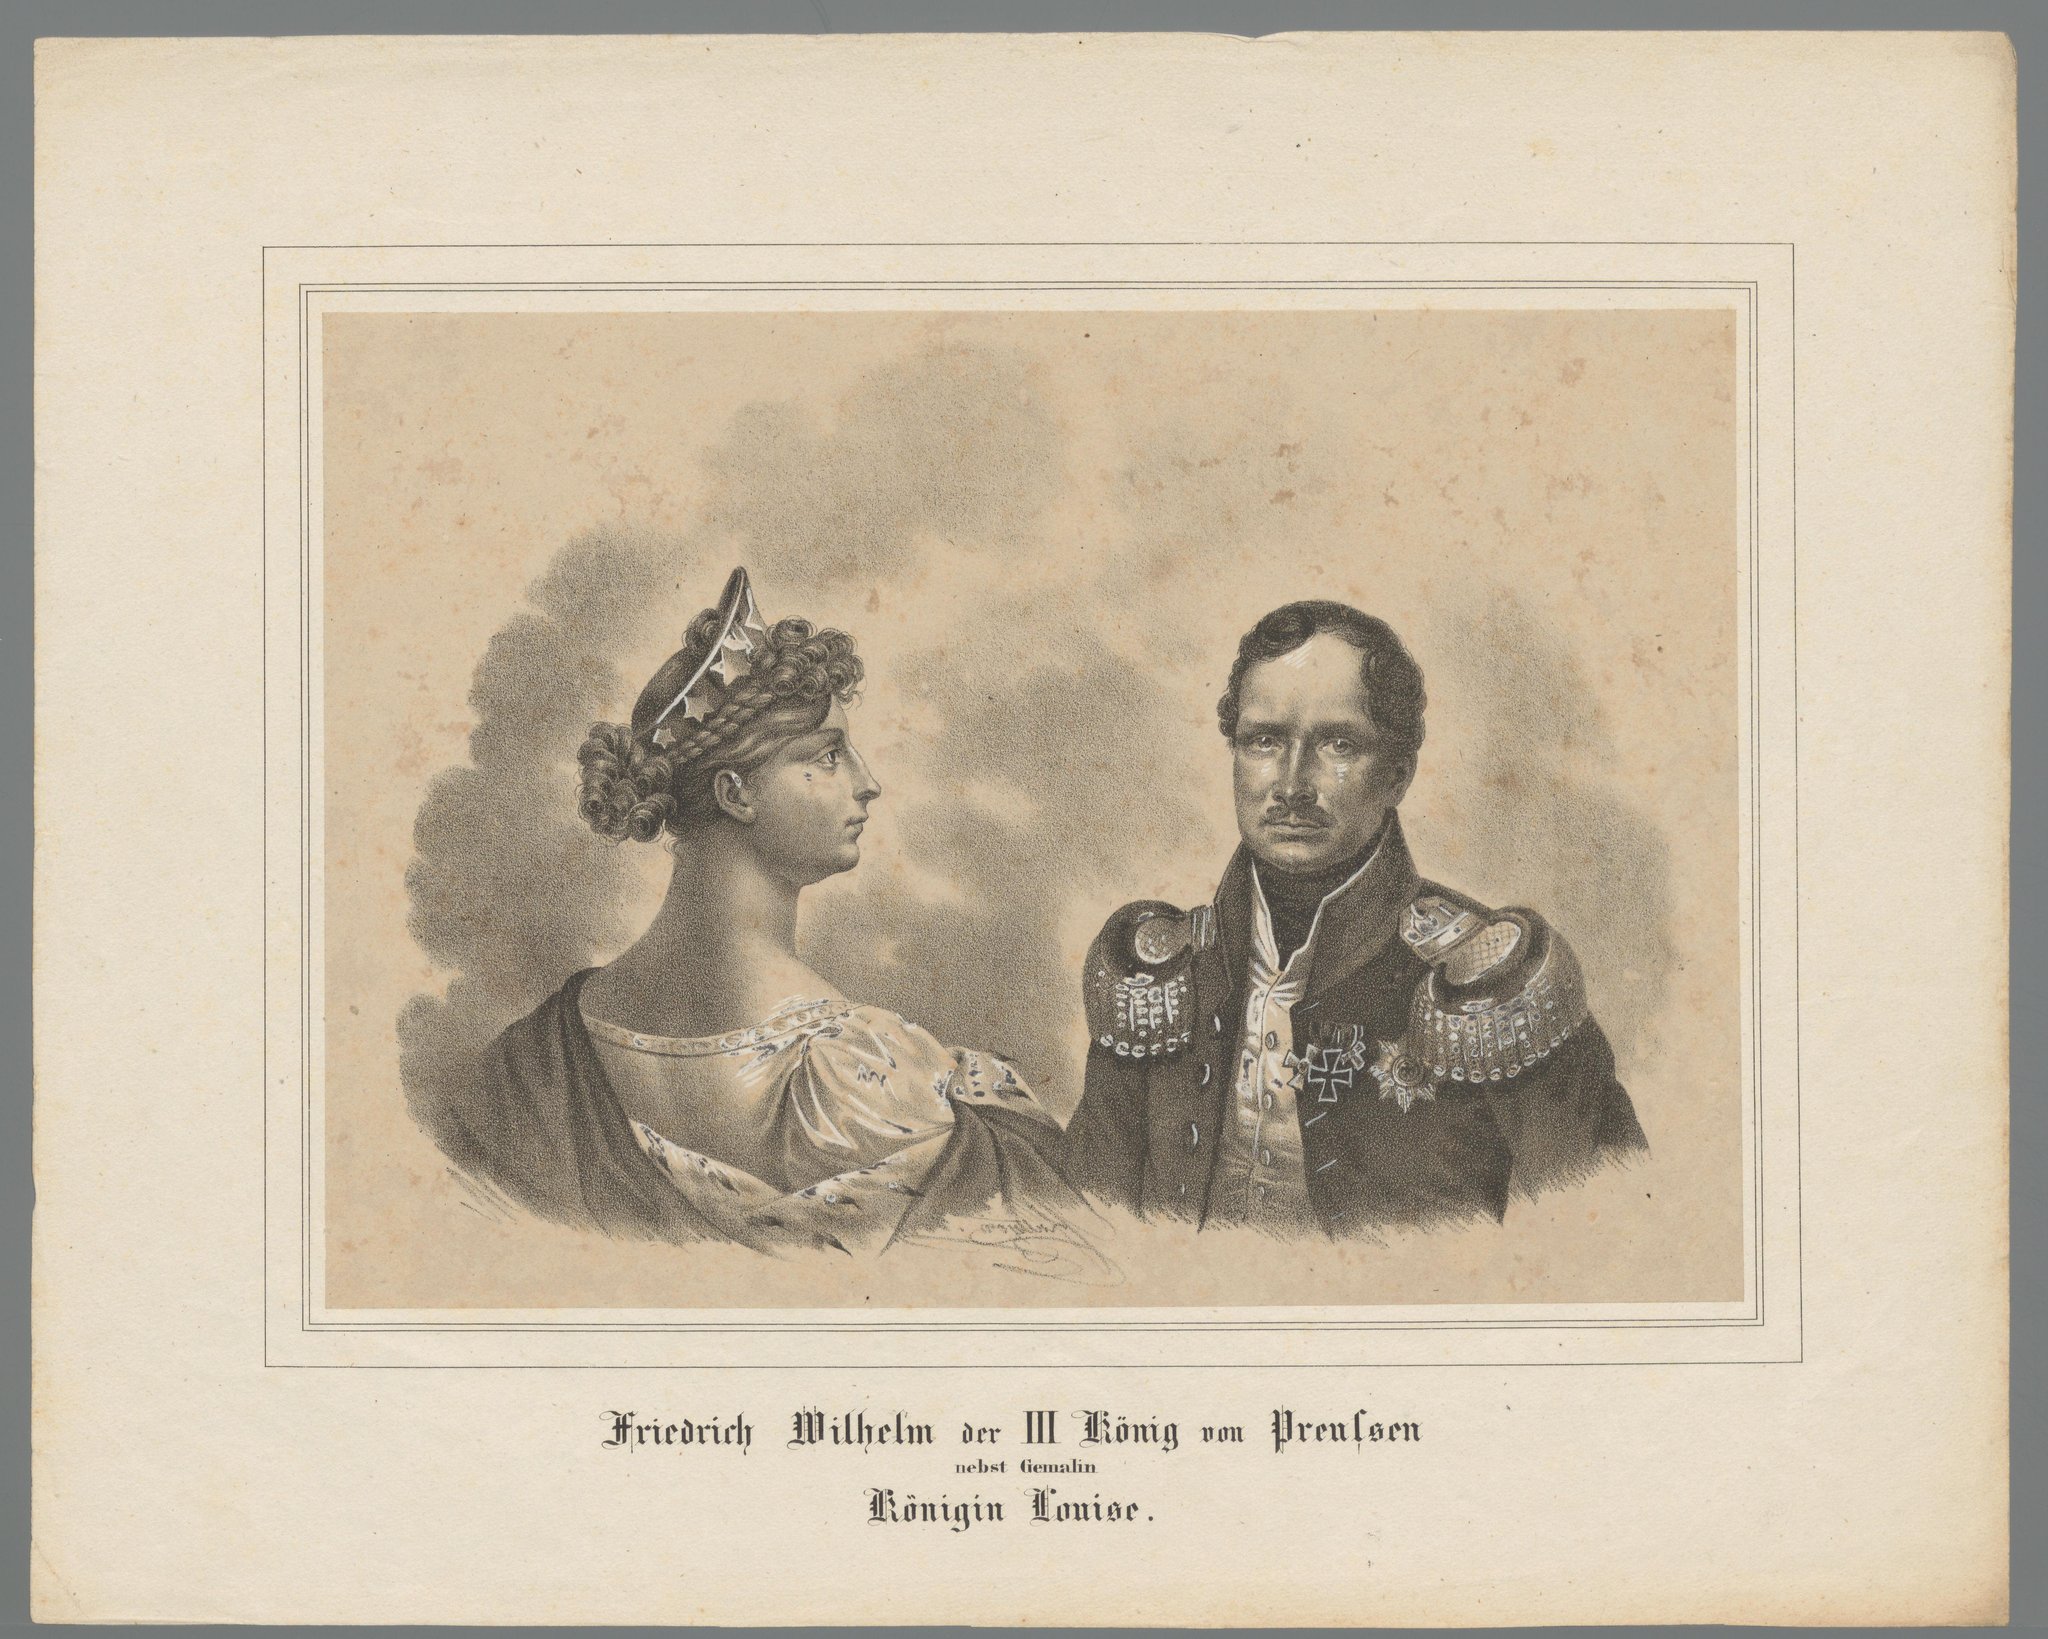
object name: print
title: Portret van Frederik Willem III en Louise van Mecklenburg-Strelitz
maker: karl palzow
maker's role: print maker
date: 1820-1850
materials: paper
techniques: lithograph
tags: berlin, frederik willem iii koning van pruisen, adult woman, adult man, historical persons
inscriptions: collector's mark: Lugt 2228